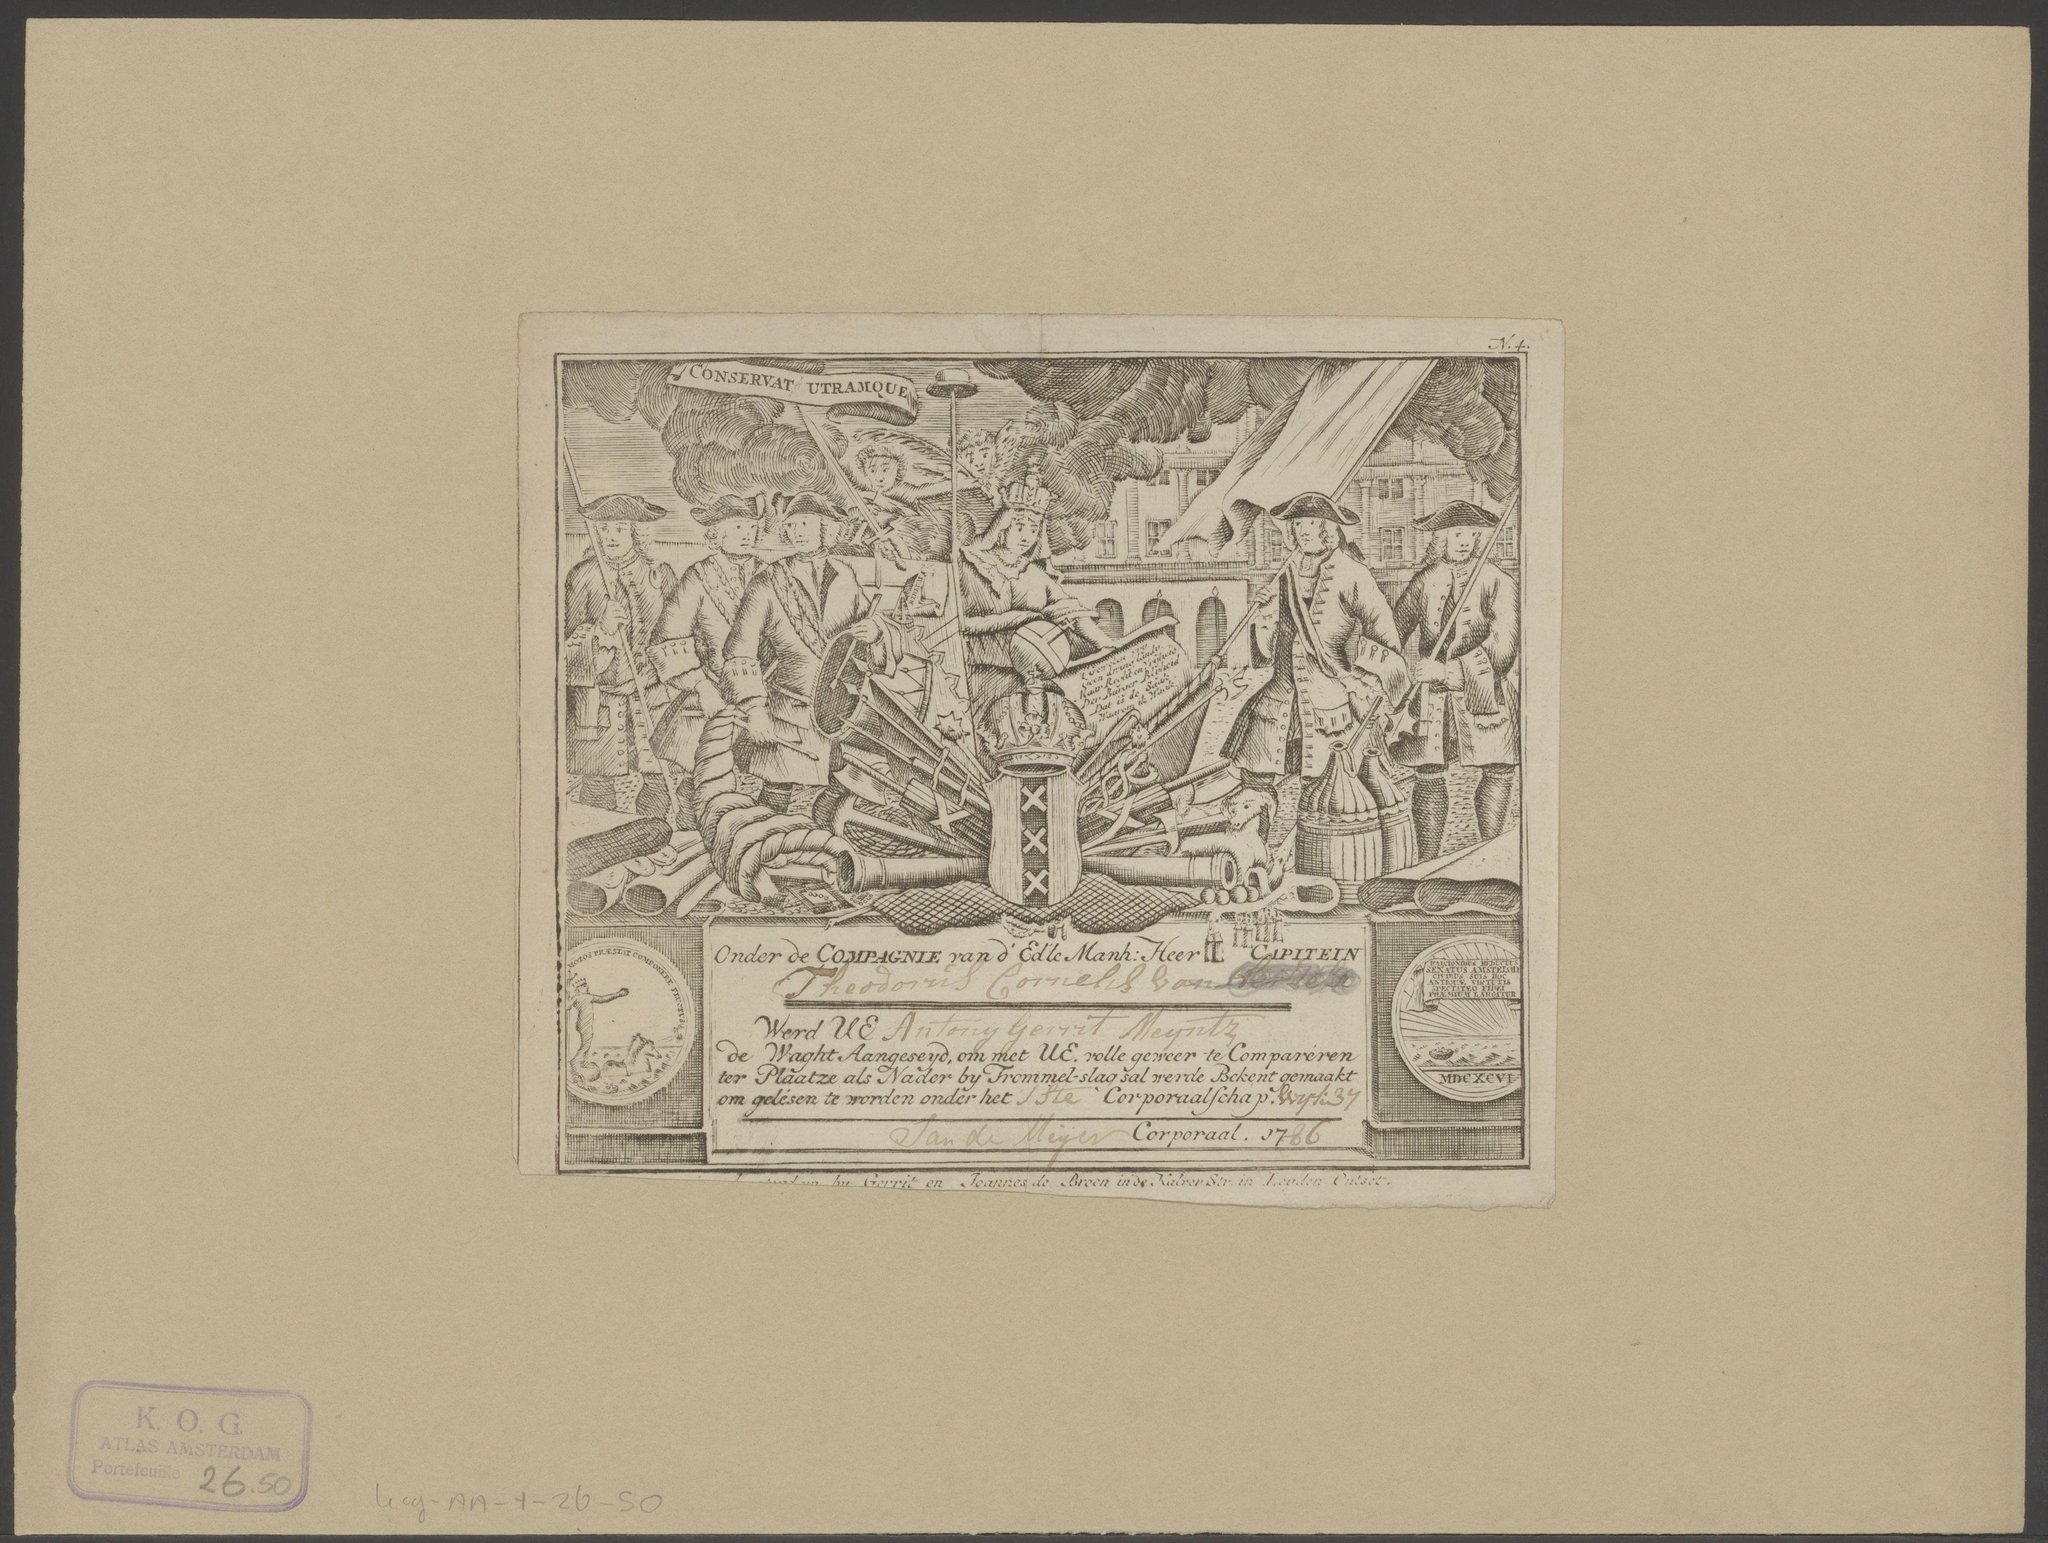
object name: print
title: Schuttersbrief van kapitein Theodorus Cornelis van Herzele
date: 1786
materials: paper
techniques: engraving, etching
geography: northern netherlands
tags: coat of arms (as symbol of the state, etc.) (+ city; municipal), personification of a city, town-patron(ess), military service (+ citizen soldiery, civil guard, citizen militia), amsterdam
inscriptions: collector's mark: Lugt 1641b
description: Schuttersbrief met oproep van kapitein Theodorus Cornelis van Herzele, gericht aan Antony Gerrit Meyntz, om zich bij het eerste korporaalschap van Jan de Meijer van burgerwijk XXXIV te Amsterdam te melden. Voorgedrukte brief met open delen die met pen zijn ingevuld. Rechtsboven genummerd: N. 4. Onderwerpsrubriek binnen de Atlas Amsterdam: Schutters-oproepingsbriefjes.